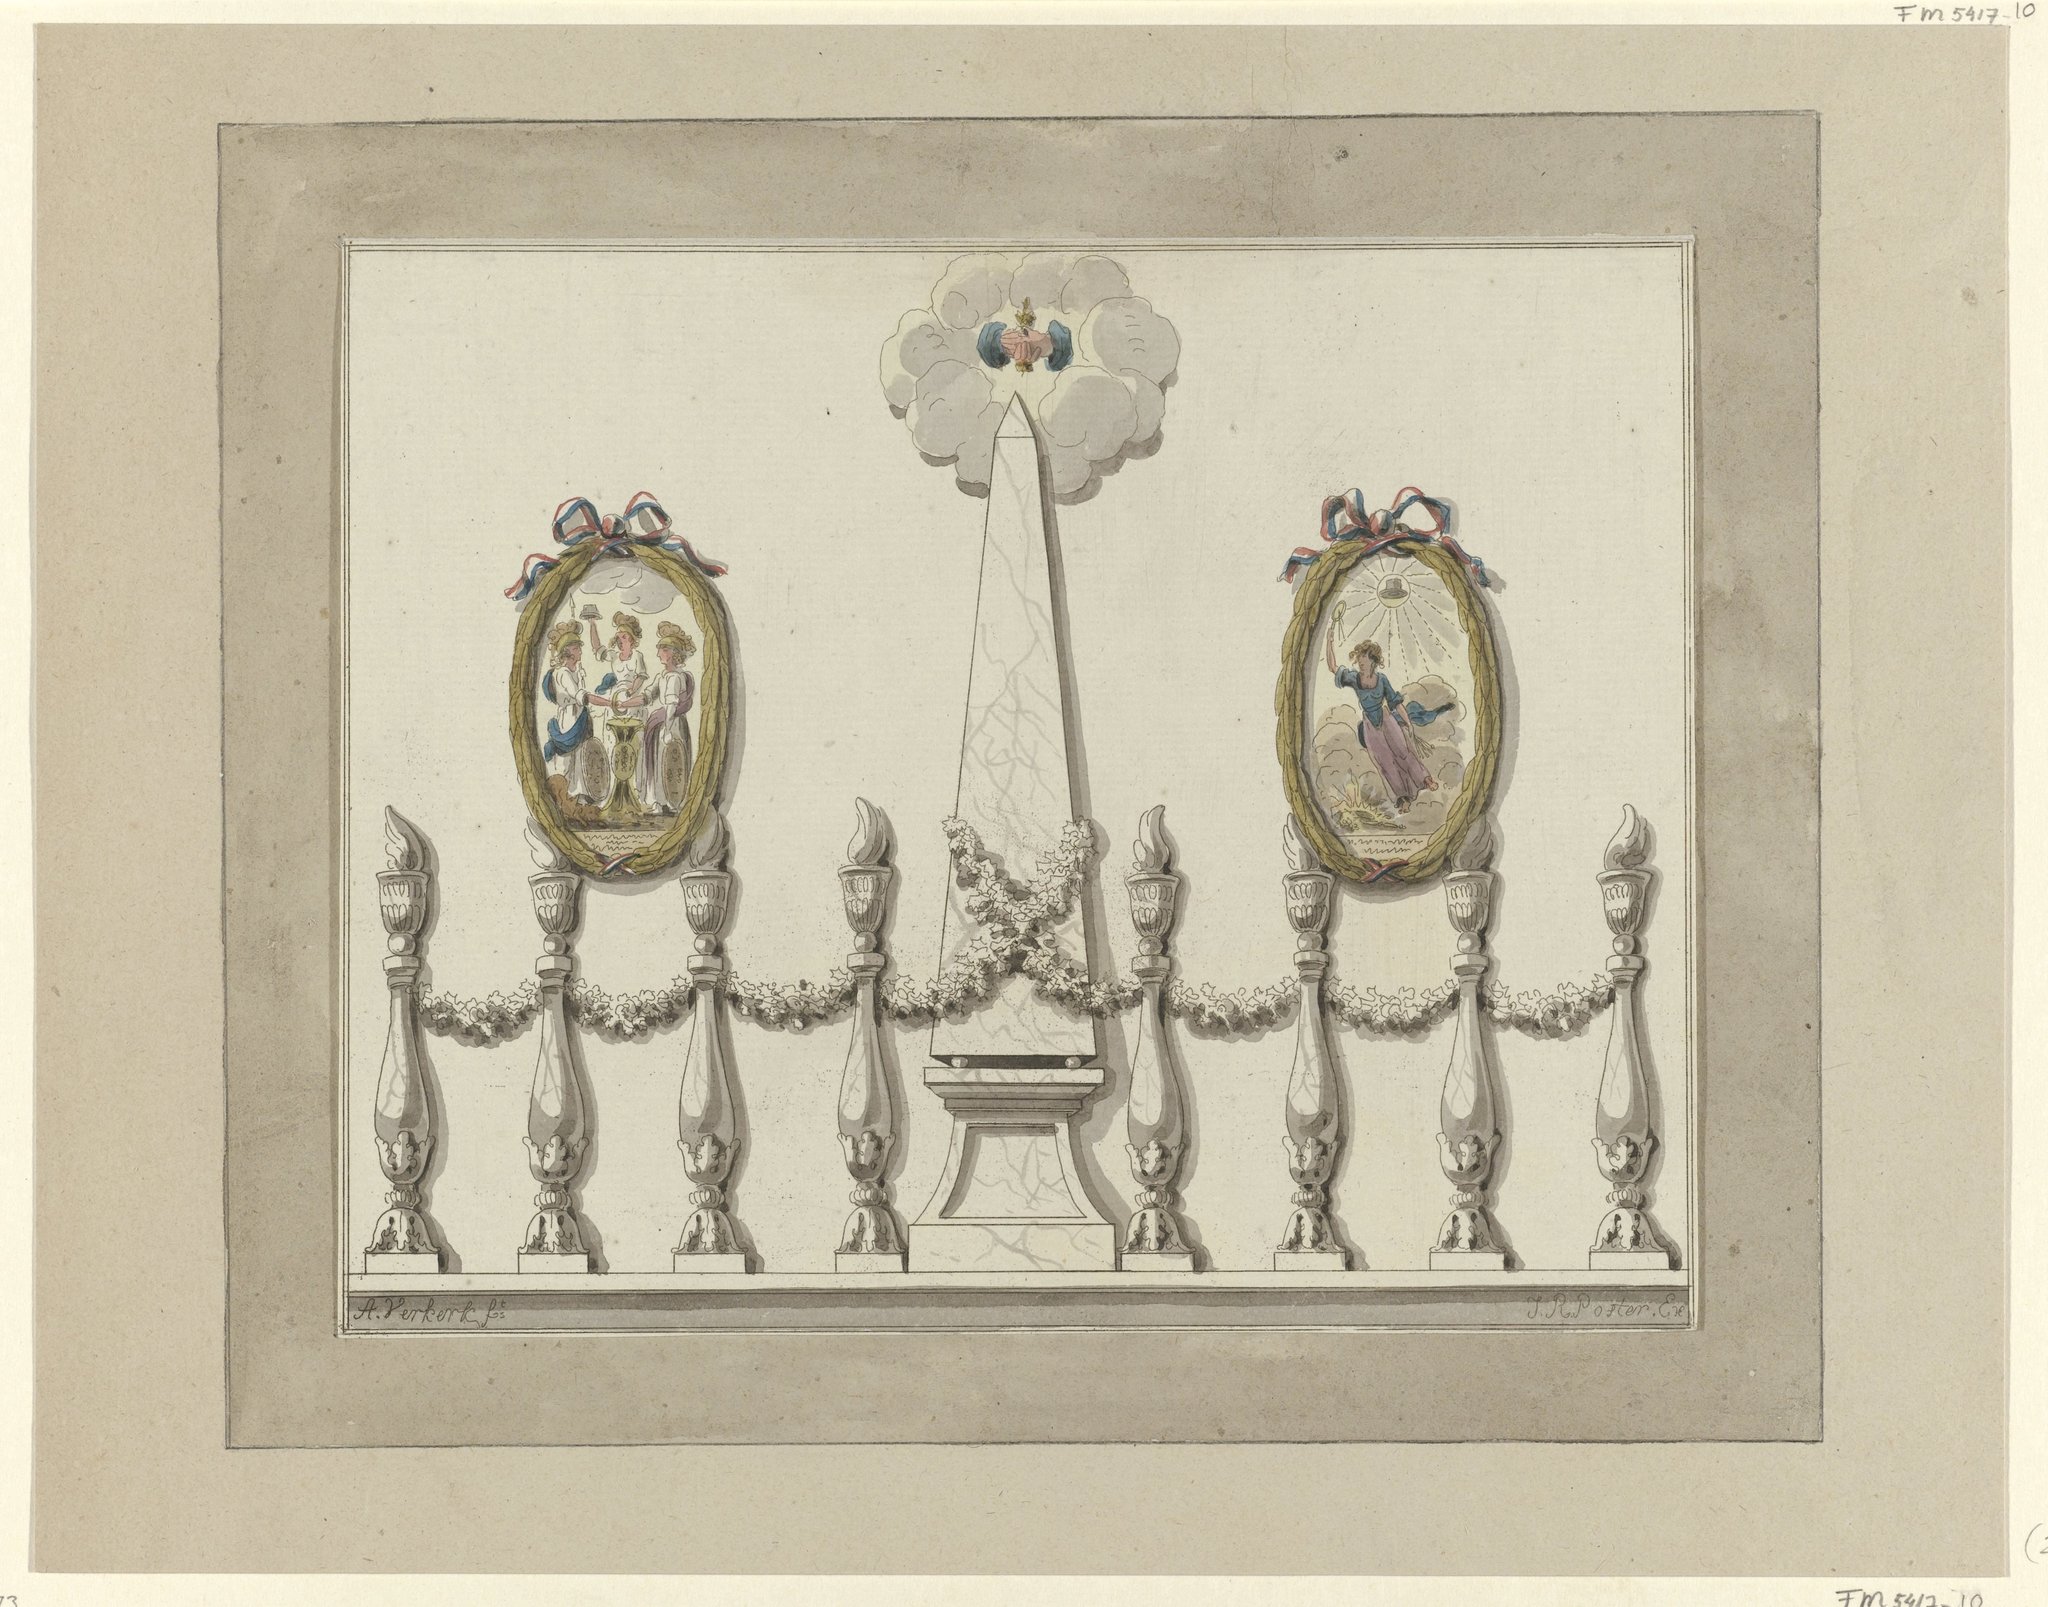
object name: print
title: Tien platen van de decoraties bij het Alliantiefeest te Amsterdam in 1795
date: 1795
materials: paper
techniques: etching, hand coloring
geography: amsterdam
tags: festivities on events of national importance (+ festive decoration ~ festive activities), amsterdam, alliance with france (1785)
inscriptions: collector's mark: Lugt 2228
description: De Alliantie gesloten tussen de Franse en de Bataafse Republiek op 16 mei 1795 en de Aanstaande Eenheid en Onverdeelbaarheid van het Bataafse Gemenebest. Twee allegorische decoraties op de gevel van het Stadhuis op de Dam te Amsterdam bij het Alliantiefeest op 19 juni 1795. Onderdeel van een serie van tien platen.